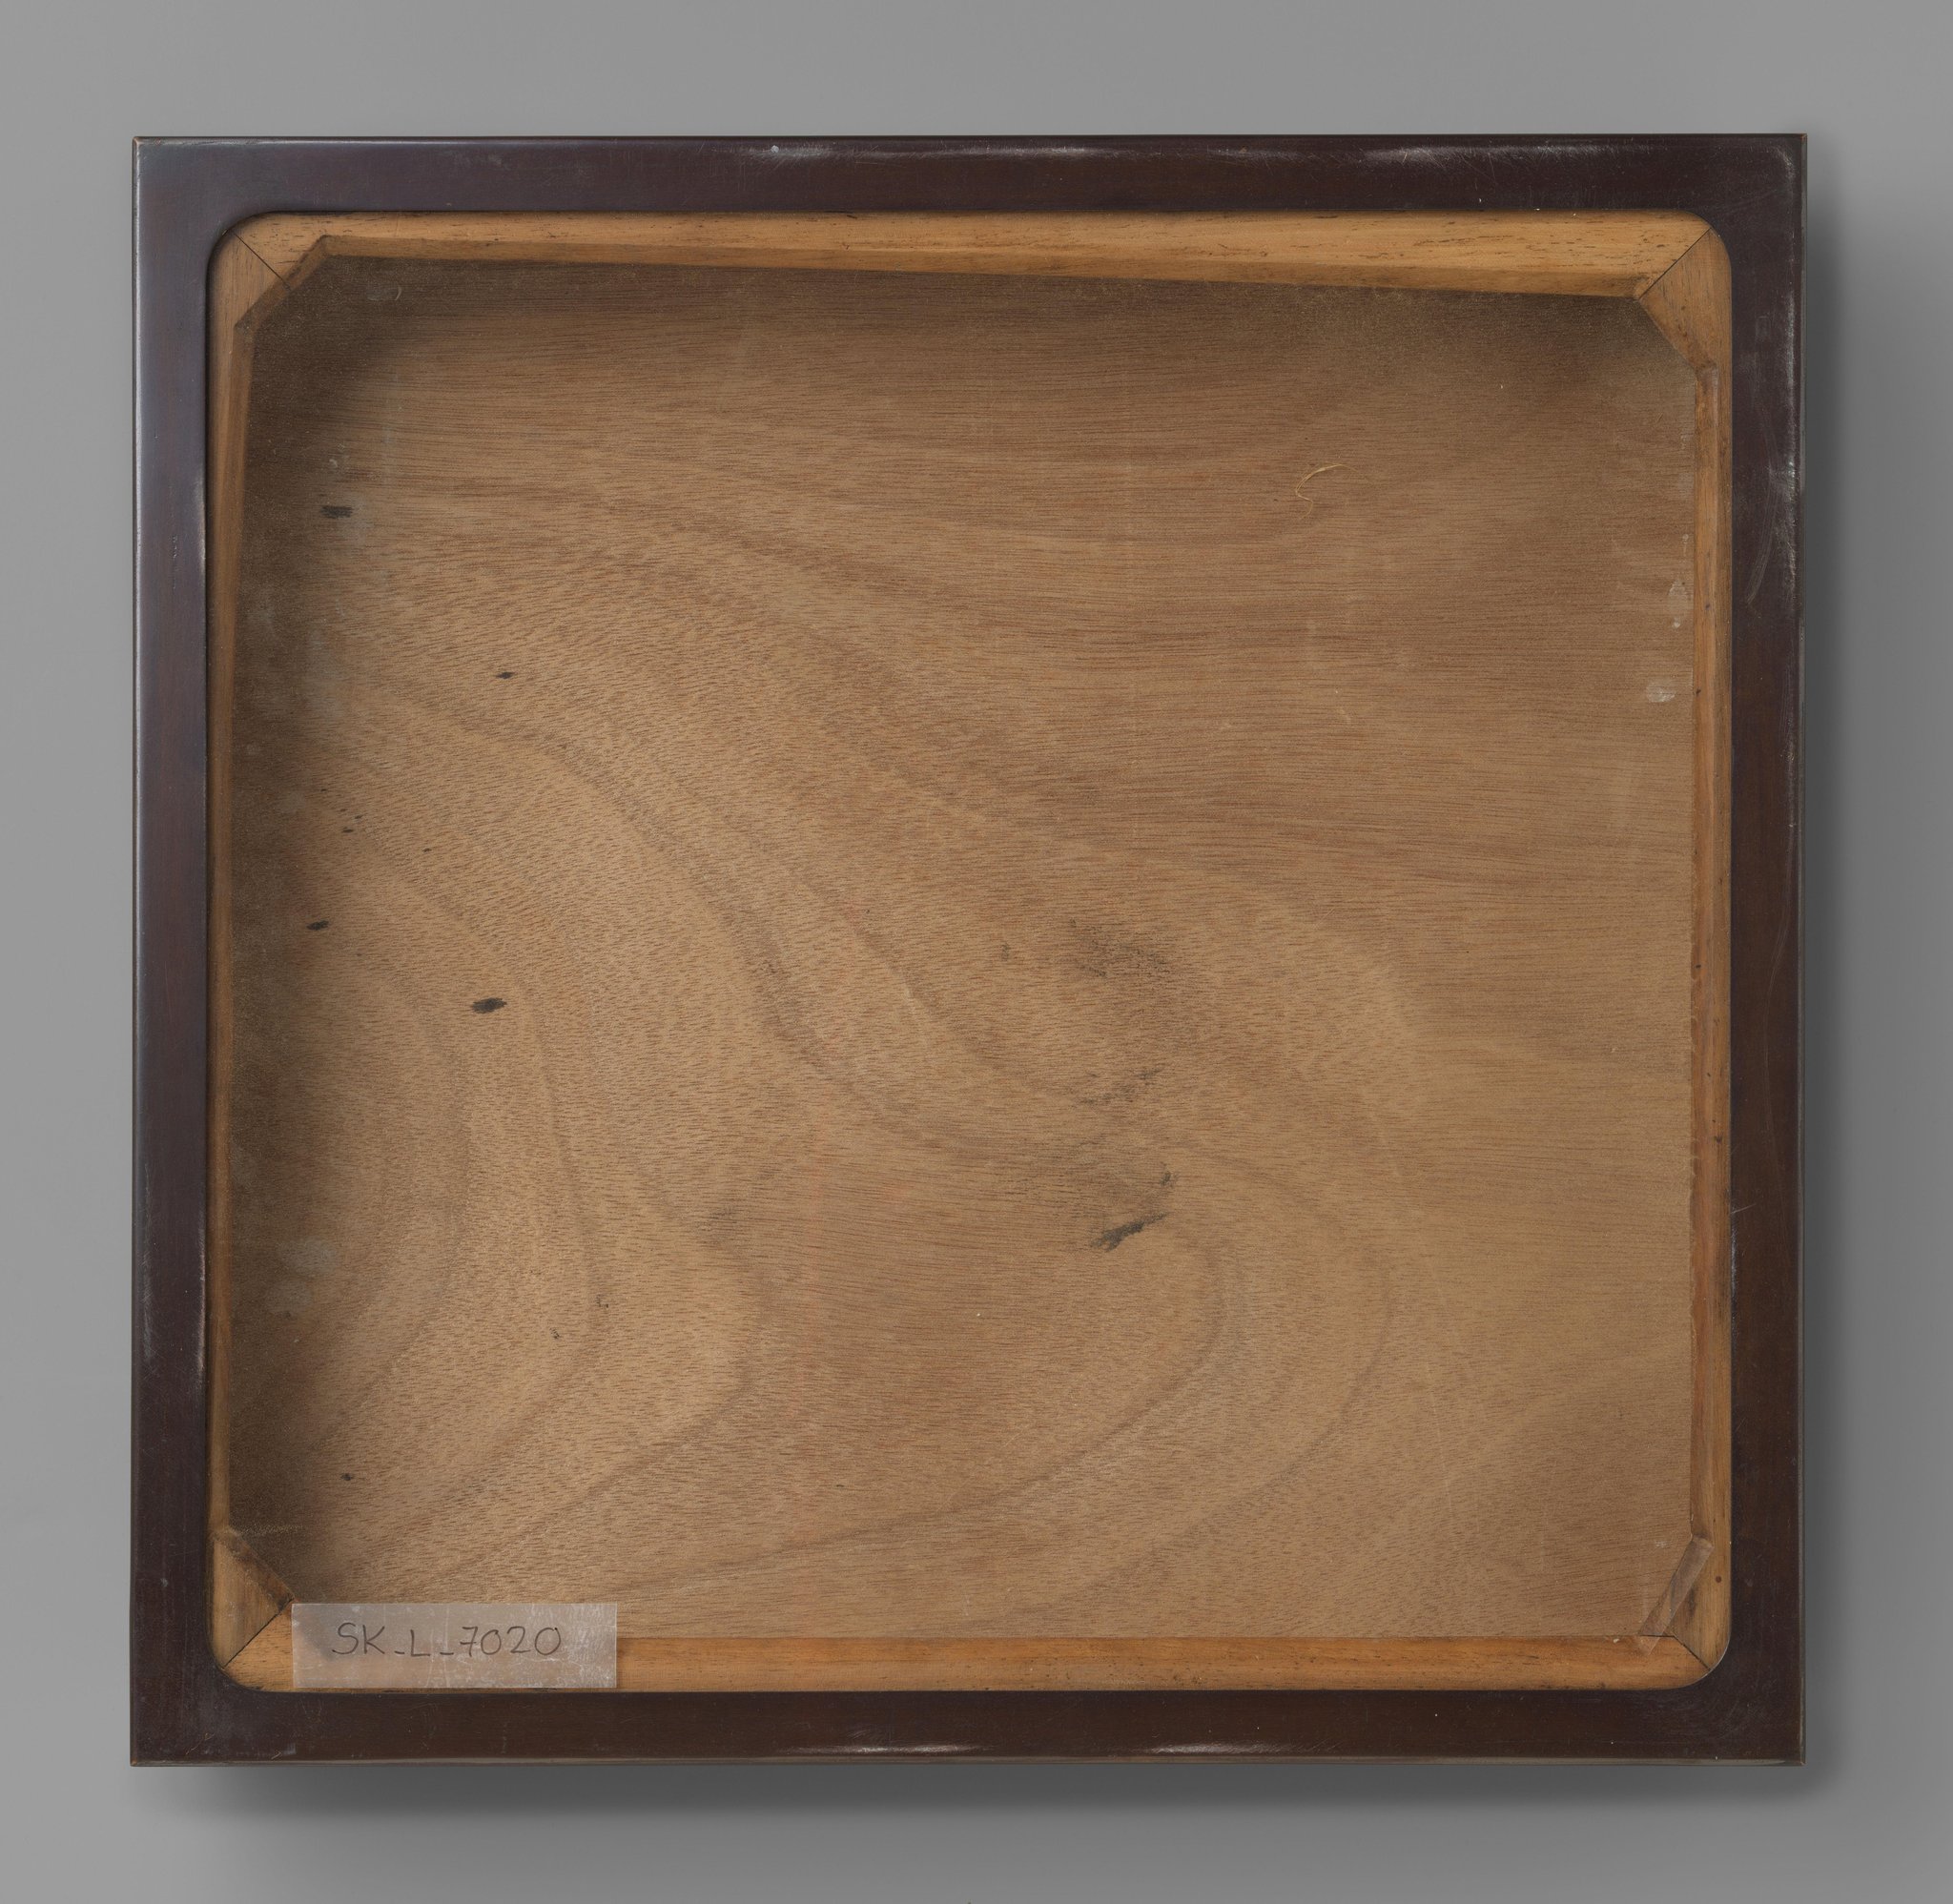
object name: frame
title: Lijst voor fragment van een Chinese muurschildering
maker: Anonymous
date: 1900-1950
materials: glass, wood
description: Lijst van hout en glas bestaande uit vier onderdelen.